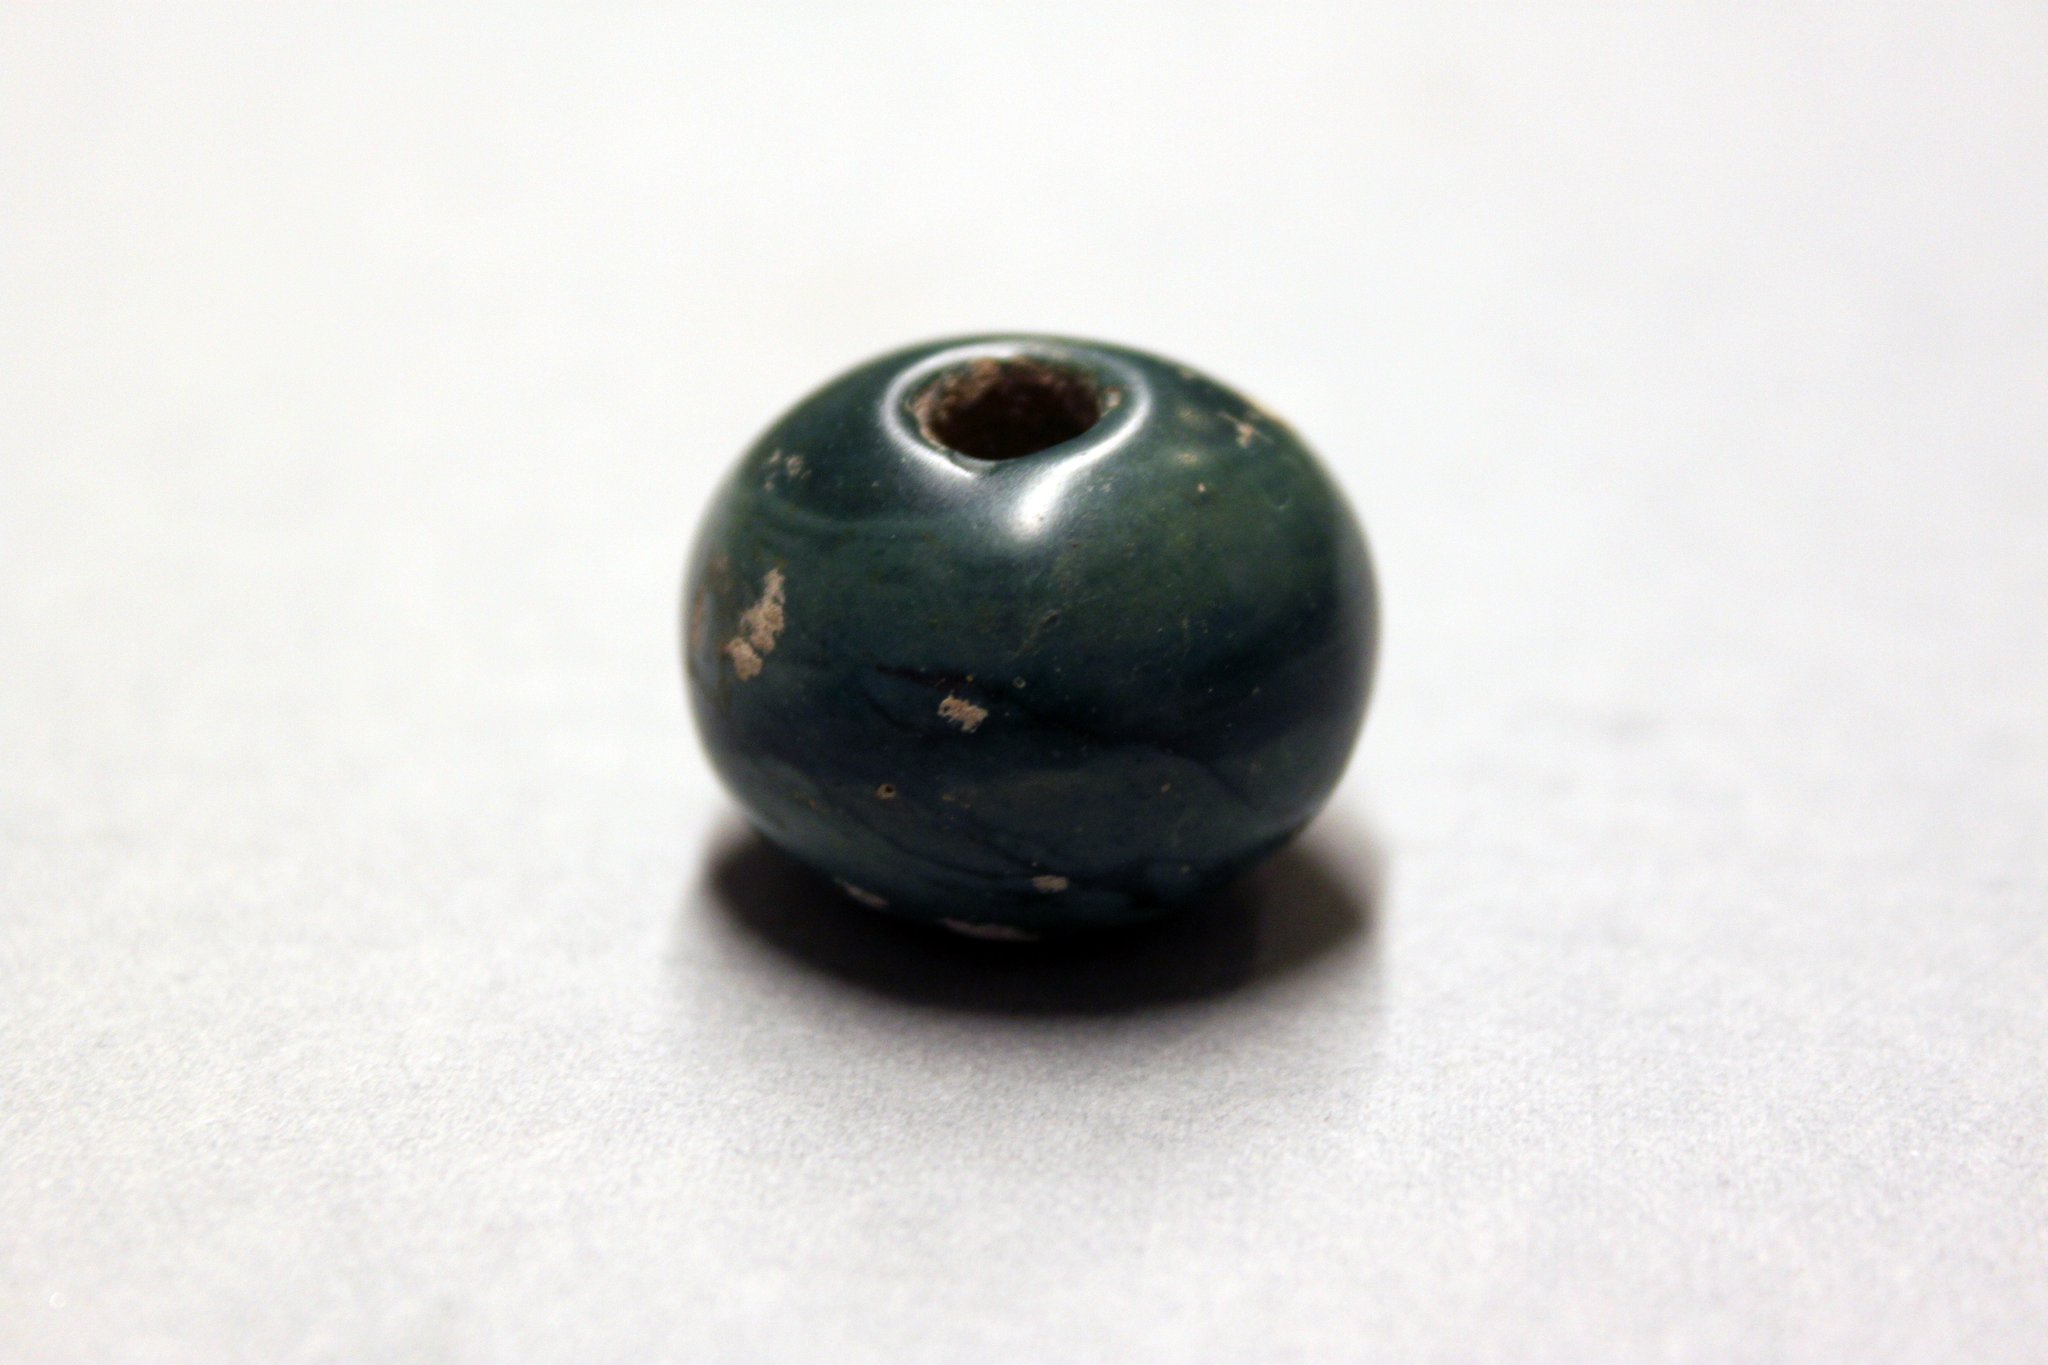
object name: bead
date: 701-1300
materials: stone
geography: iran